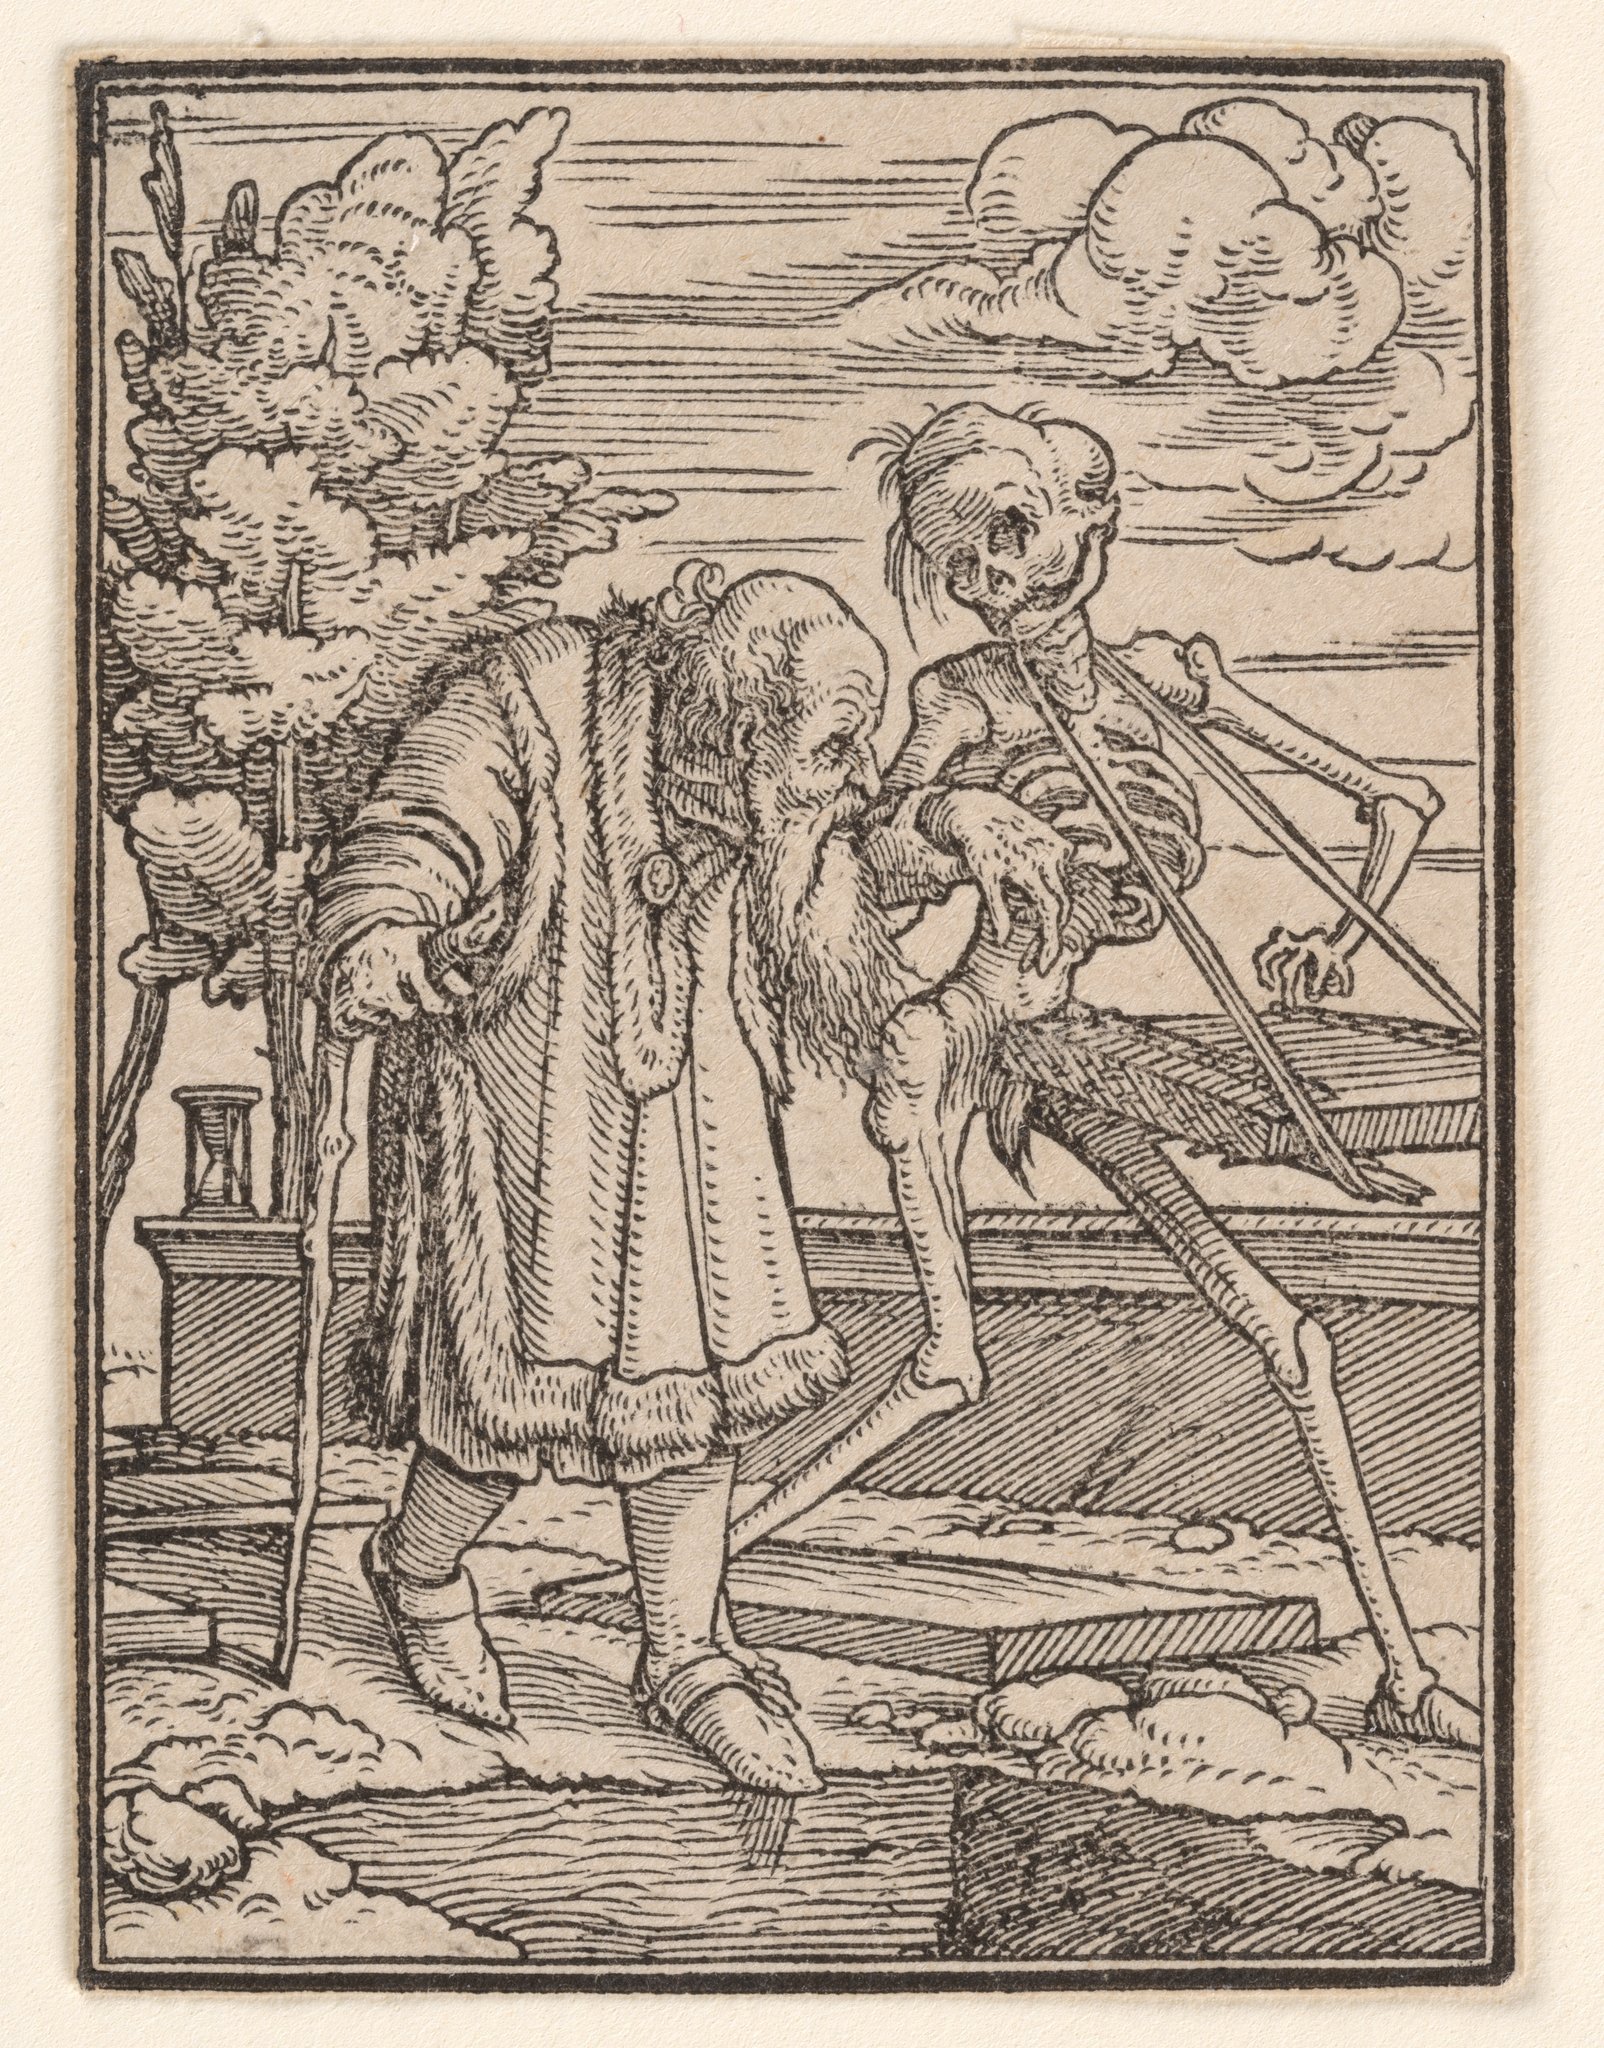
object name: print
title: The Old Man, from "The Dance of Death"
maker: hans holbein the younger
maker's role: artist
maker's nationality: german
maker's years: 1497-1543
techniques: woodcut